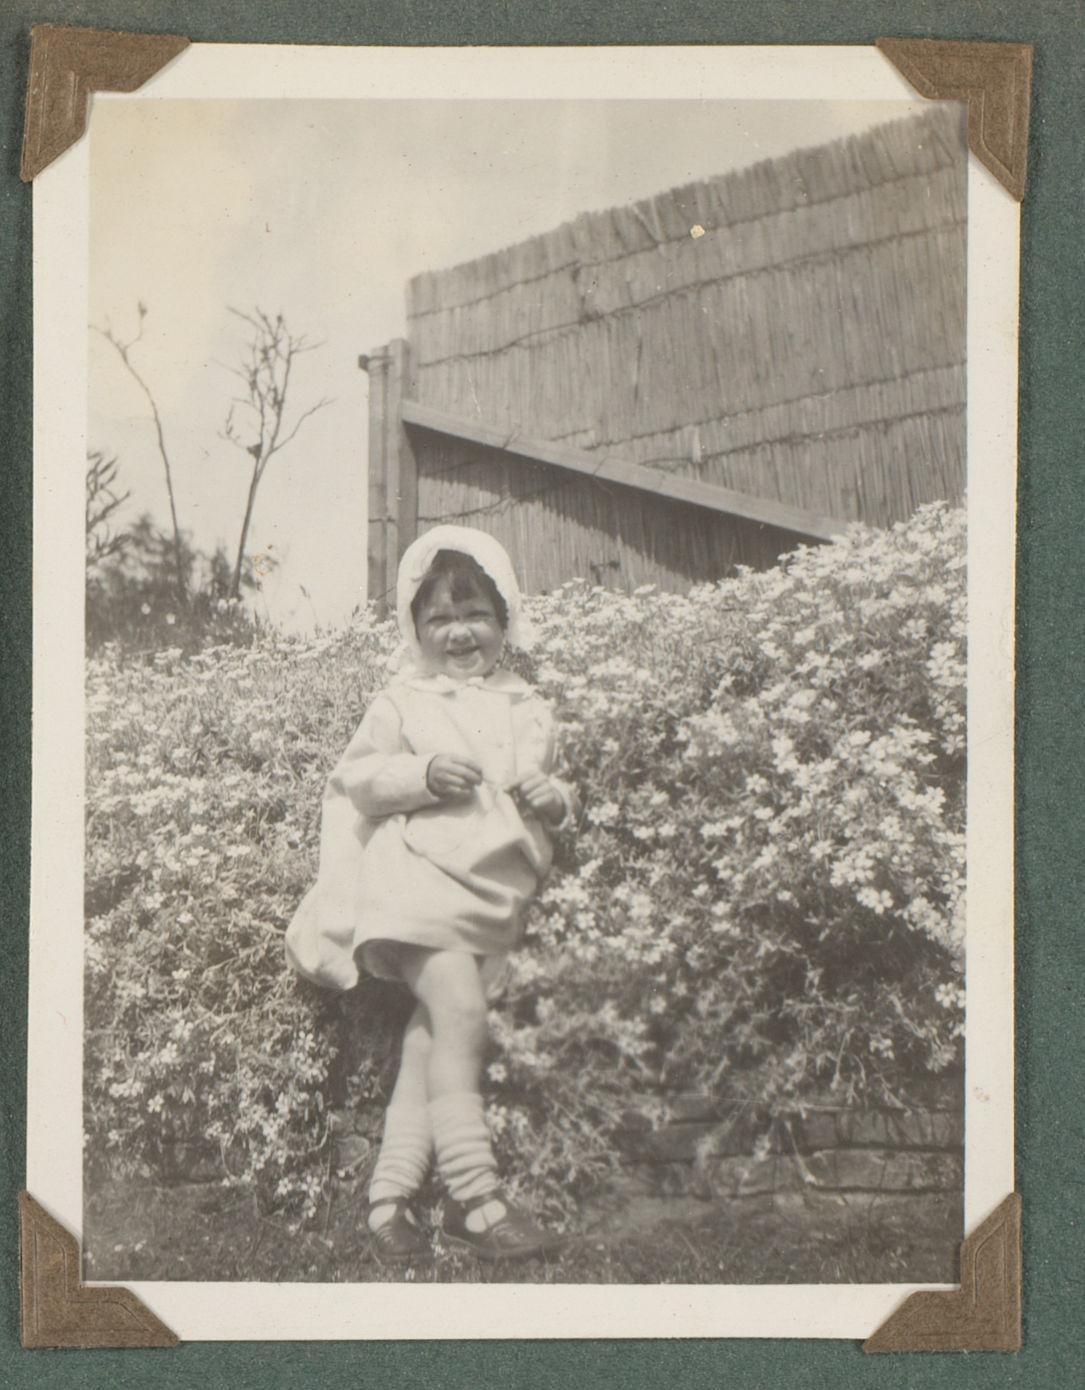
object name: photograph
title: Vier foto's van kinderen van familie Onnen-Van den Berg tijdens een vakantie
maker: Anonymous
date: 1920-1930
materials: paper, cardboard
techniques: gelatin silver print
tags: child, historical persons, family life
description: Deze foto's maken deel uit van een album.